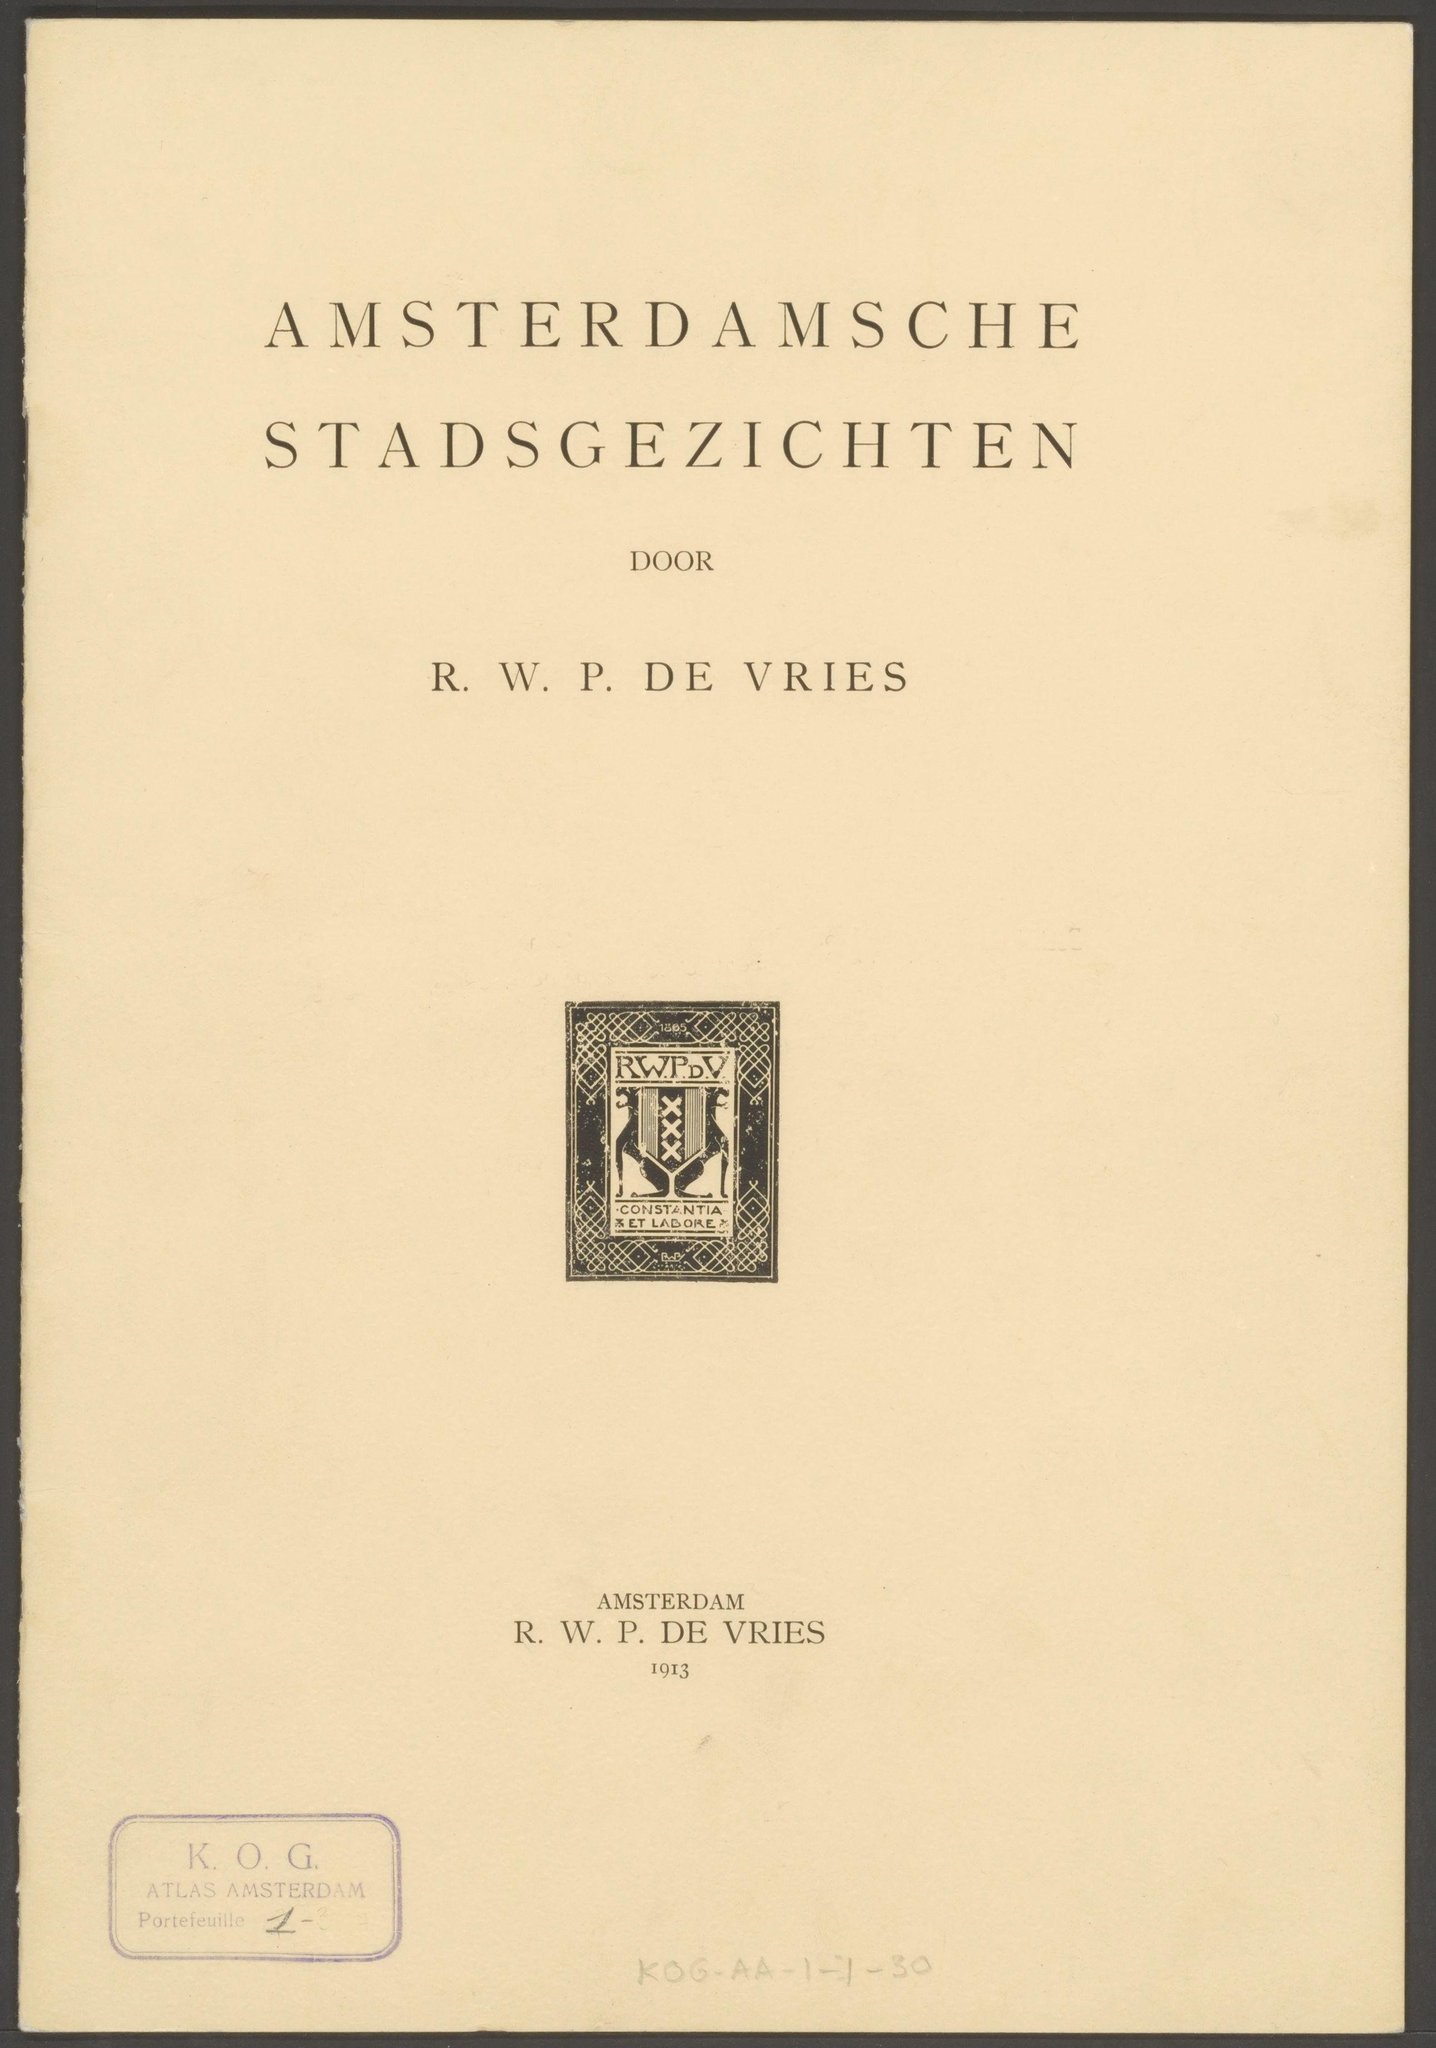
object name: text sheet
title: Tekstboek met beschrijvingen van Amsterdamse Stadsgezichten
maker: reinier willem petrus de vries (1874-1953)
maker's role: draughtsman, print maker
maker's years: 1874-1953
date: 1913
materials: metal, paper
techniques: letterpress printing, stapling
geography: amsterdam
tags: city-view in general; 'veduta', amsterdam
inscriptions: collector's mark: ‘1’ Lugt 1641b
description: Onderwerpsrubriek binnen de Atlas Amsterdam: Titels en voorberichten. Tekstboek bestaande uit 16 pagina's.